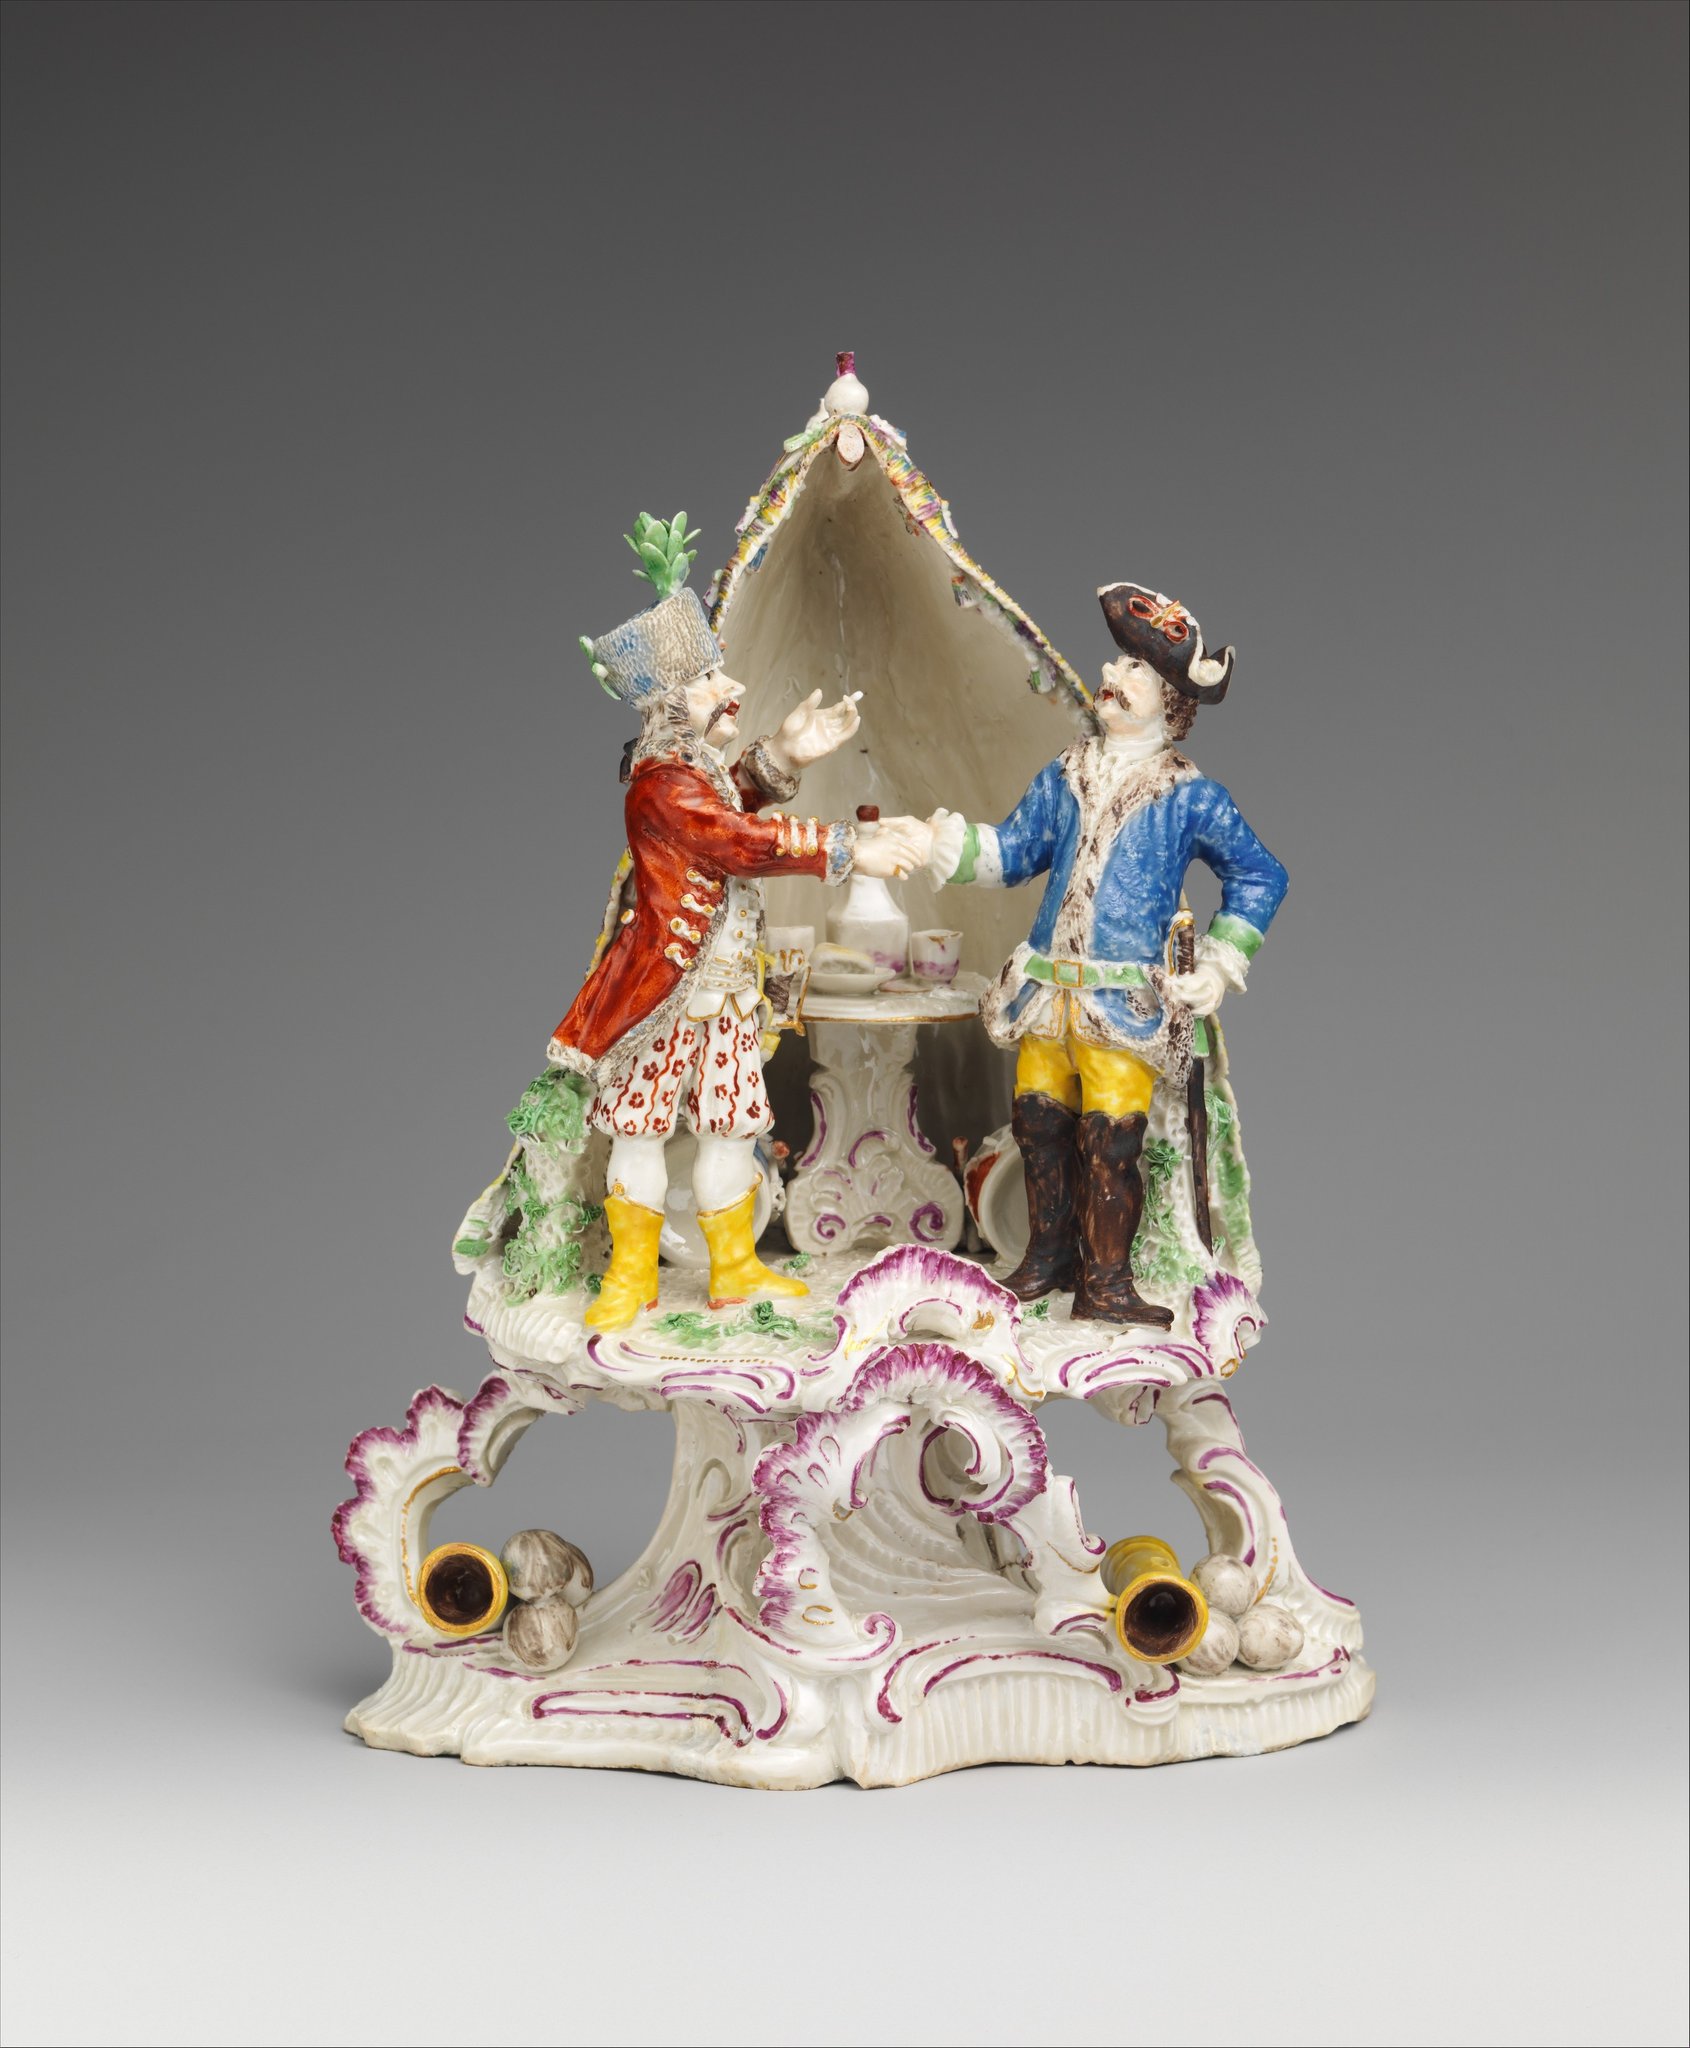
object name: group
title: Two soldiers shaking hands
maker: kelsterbach pottery and porcelain manufactory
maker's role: manufactory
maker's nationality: german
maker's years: 1758-1828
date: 1761-1764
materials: enamel, gold, hard paste porcelain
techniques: polychrome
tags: soldiers,men